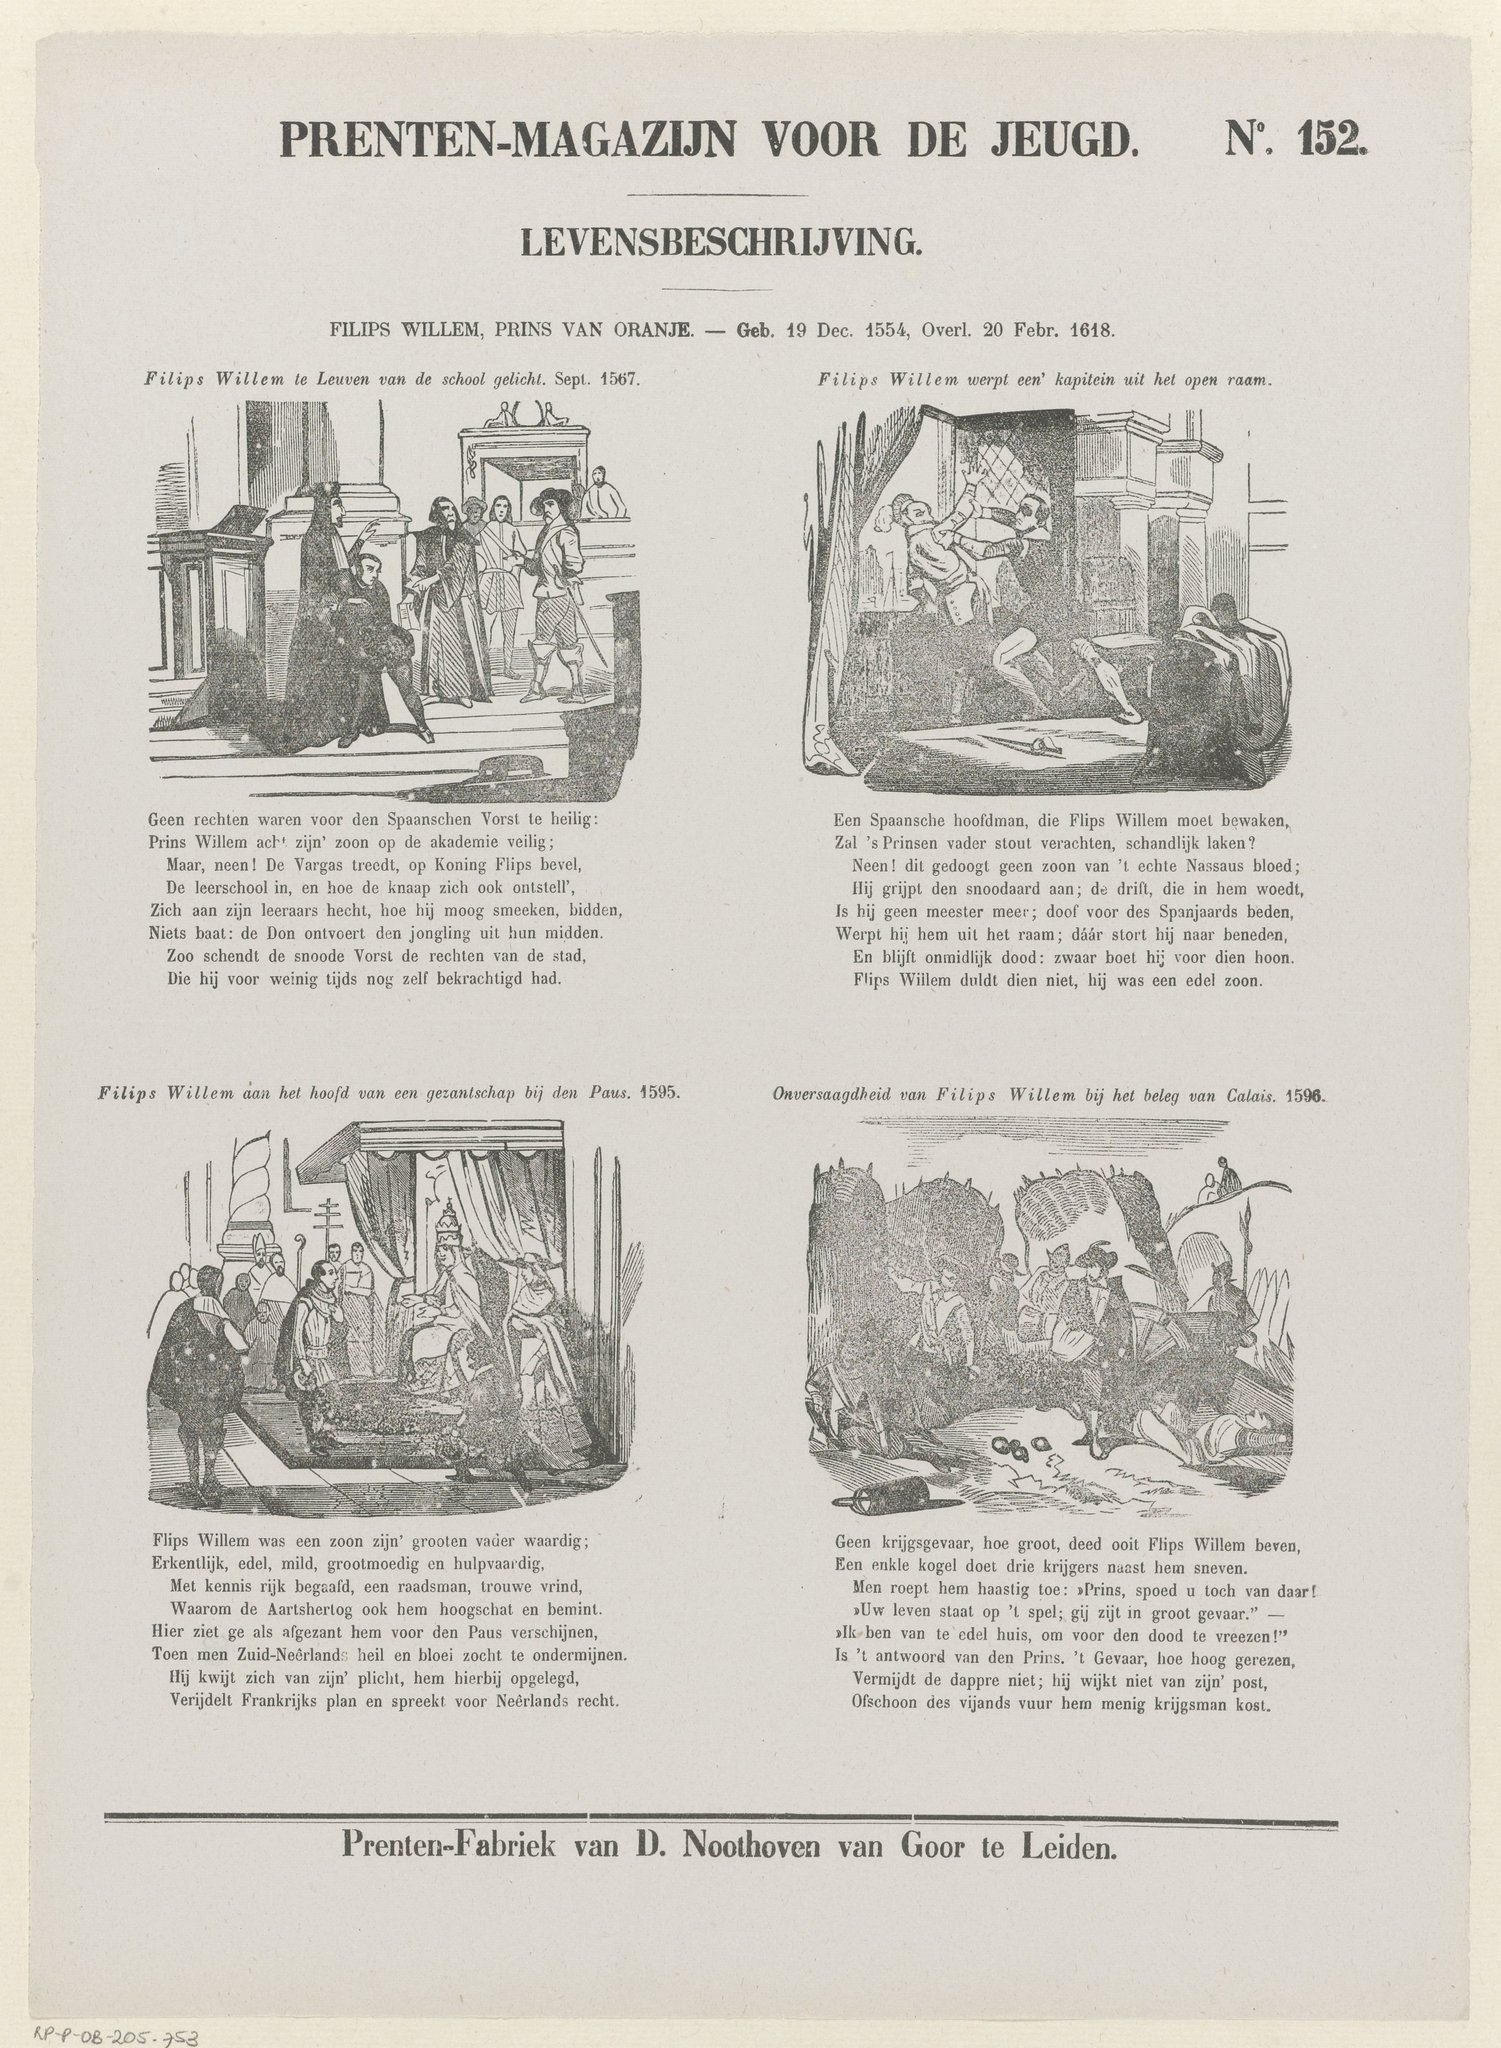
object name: print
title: Prenten-magazijn voor de jeugd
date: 1850-1881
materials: paper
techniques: letterpress printing, engraving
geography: leiden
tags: buren, bruges, filips willem (prins van oranje), historical persons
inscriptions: collector's mark: Lugt 2760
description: Blad met 4 voorstellingen uit het leven van Filips Willem. Boven elke voorstelling een titel en onder elke voorstelling een achtregelig vers. Genummerd rechtsboven: No. 152.